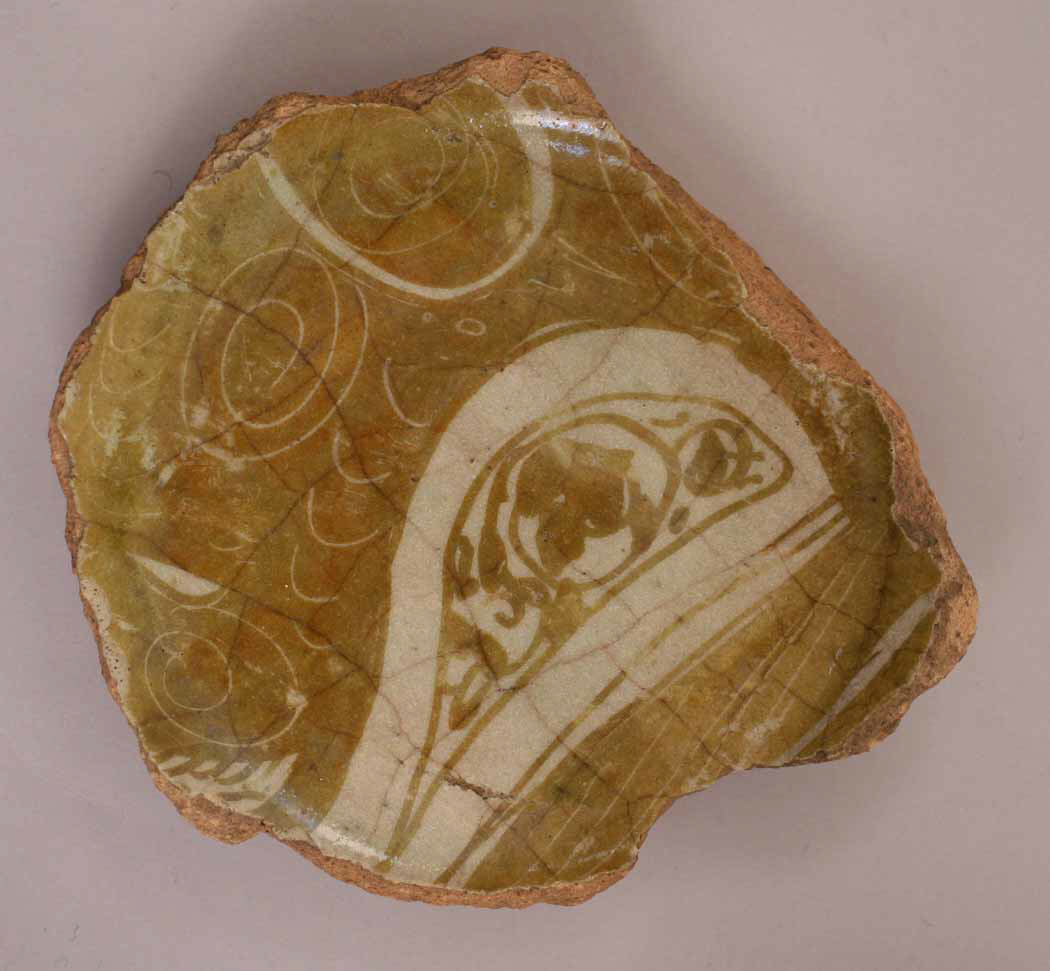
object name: ceramic fragment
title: Fragment of a Dish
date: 1001-1200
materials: earthenware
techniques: luster painting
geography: egypt